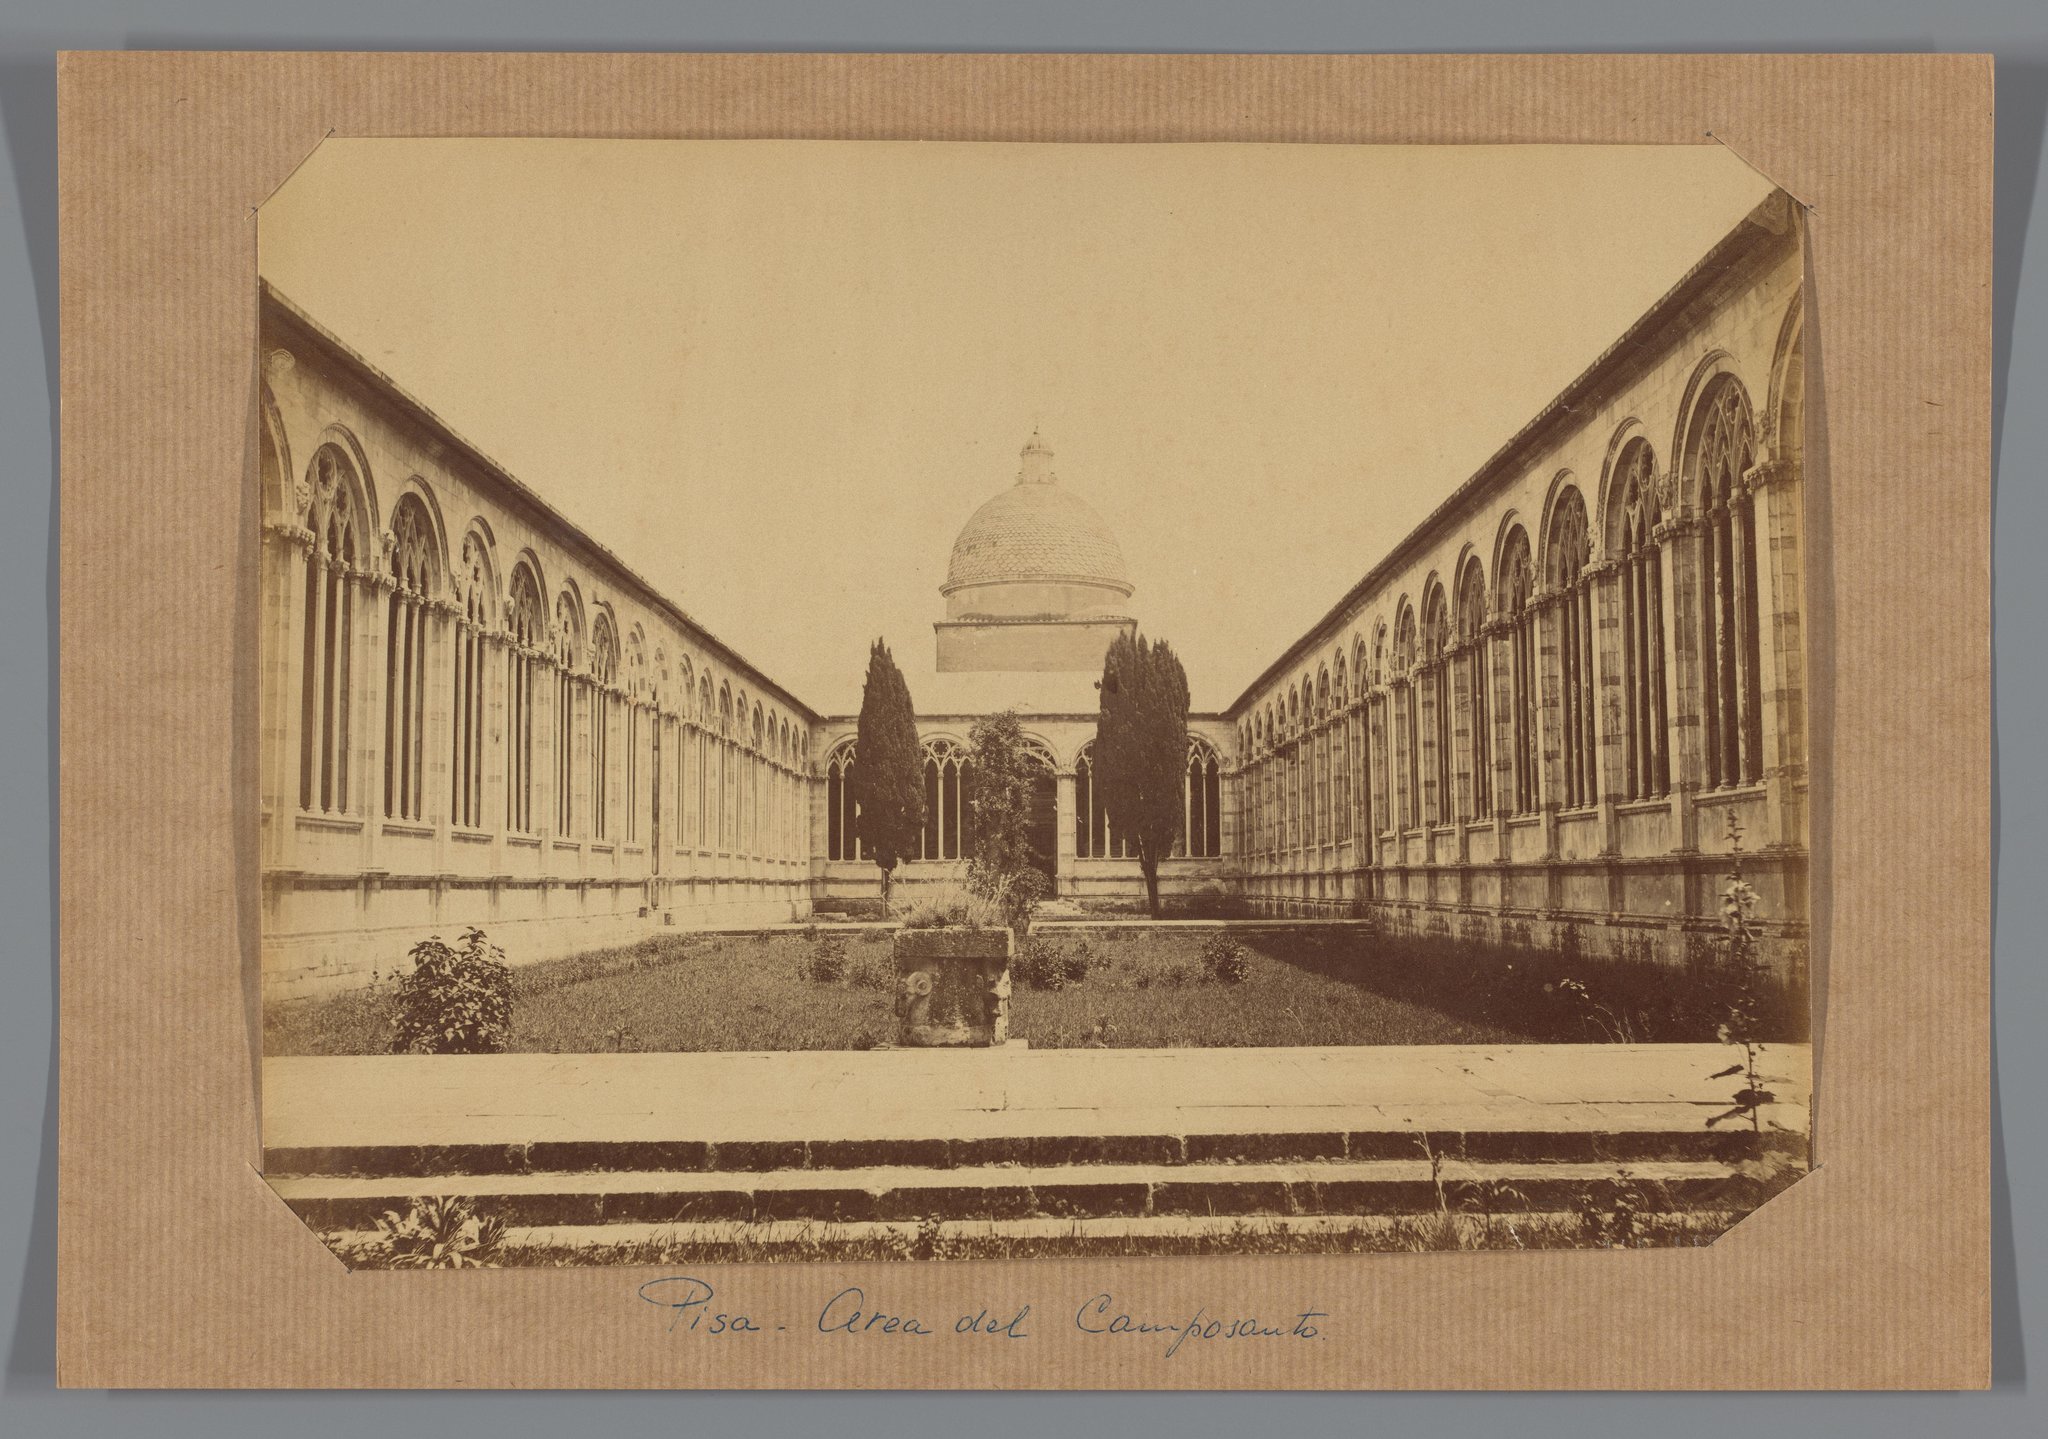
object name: photograph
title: Italië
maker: Anonymous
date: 1880-1910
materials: photographic support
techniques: albumen print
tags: italy